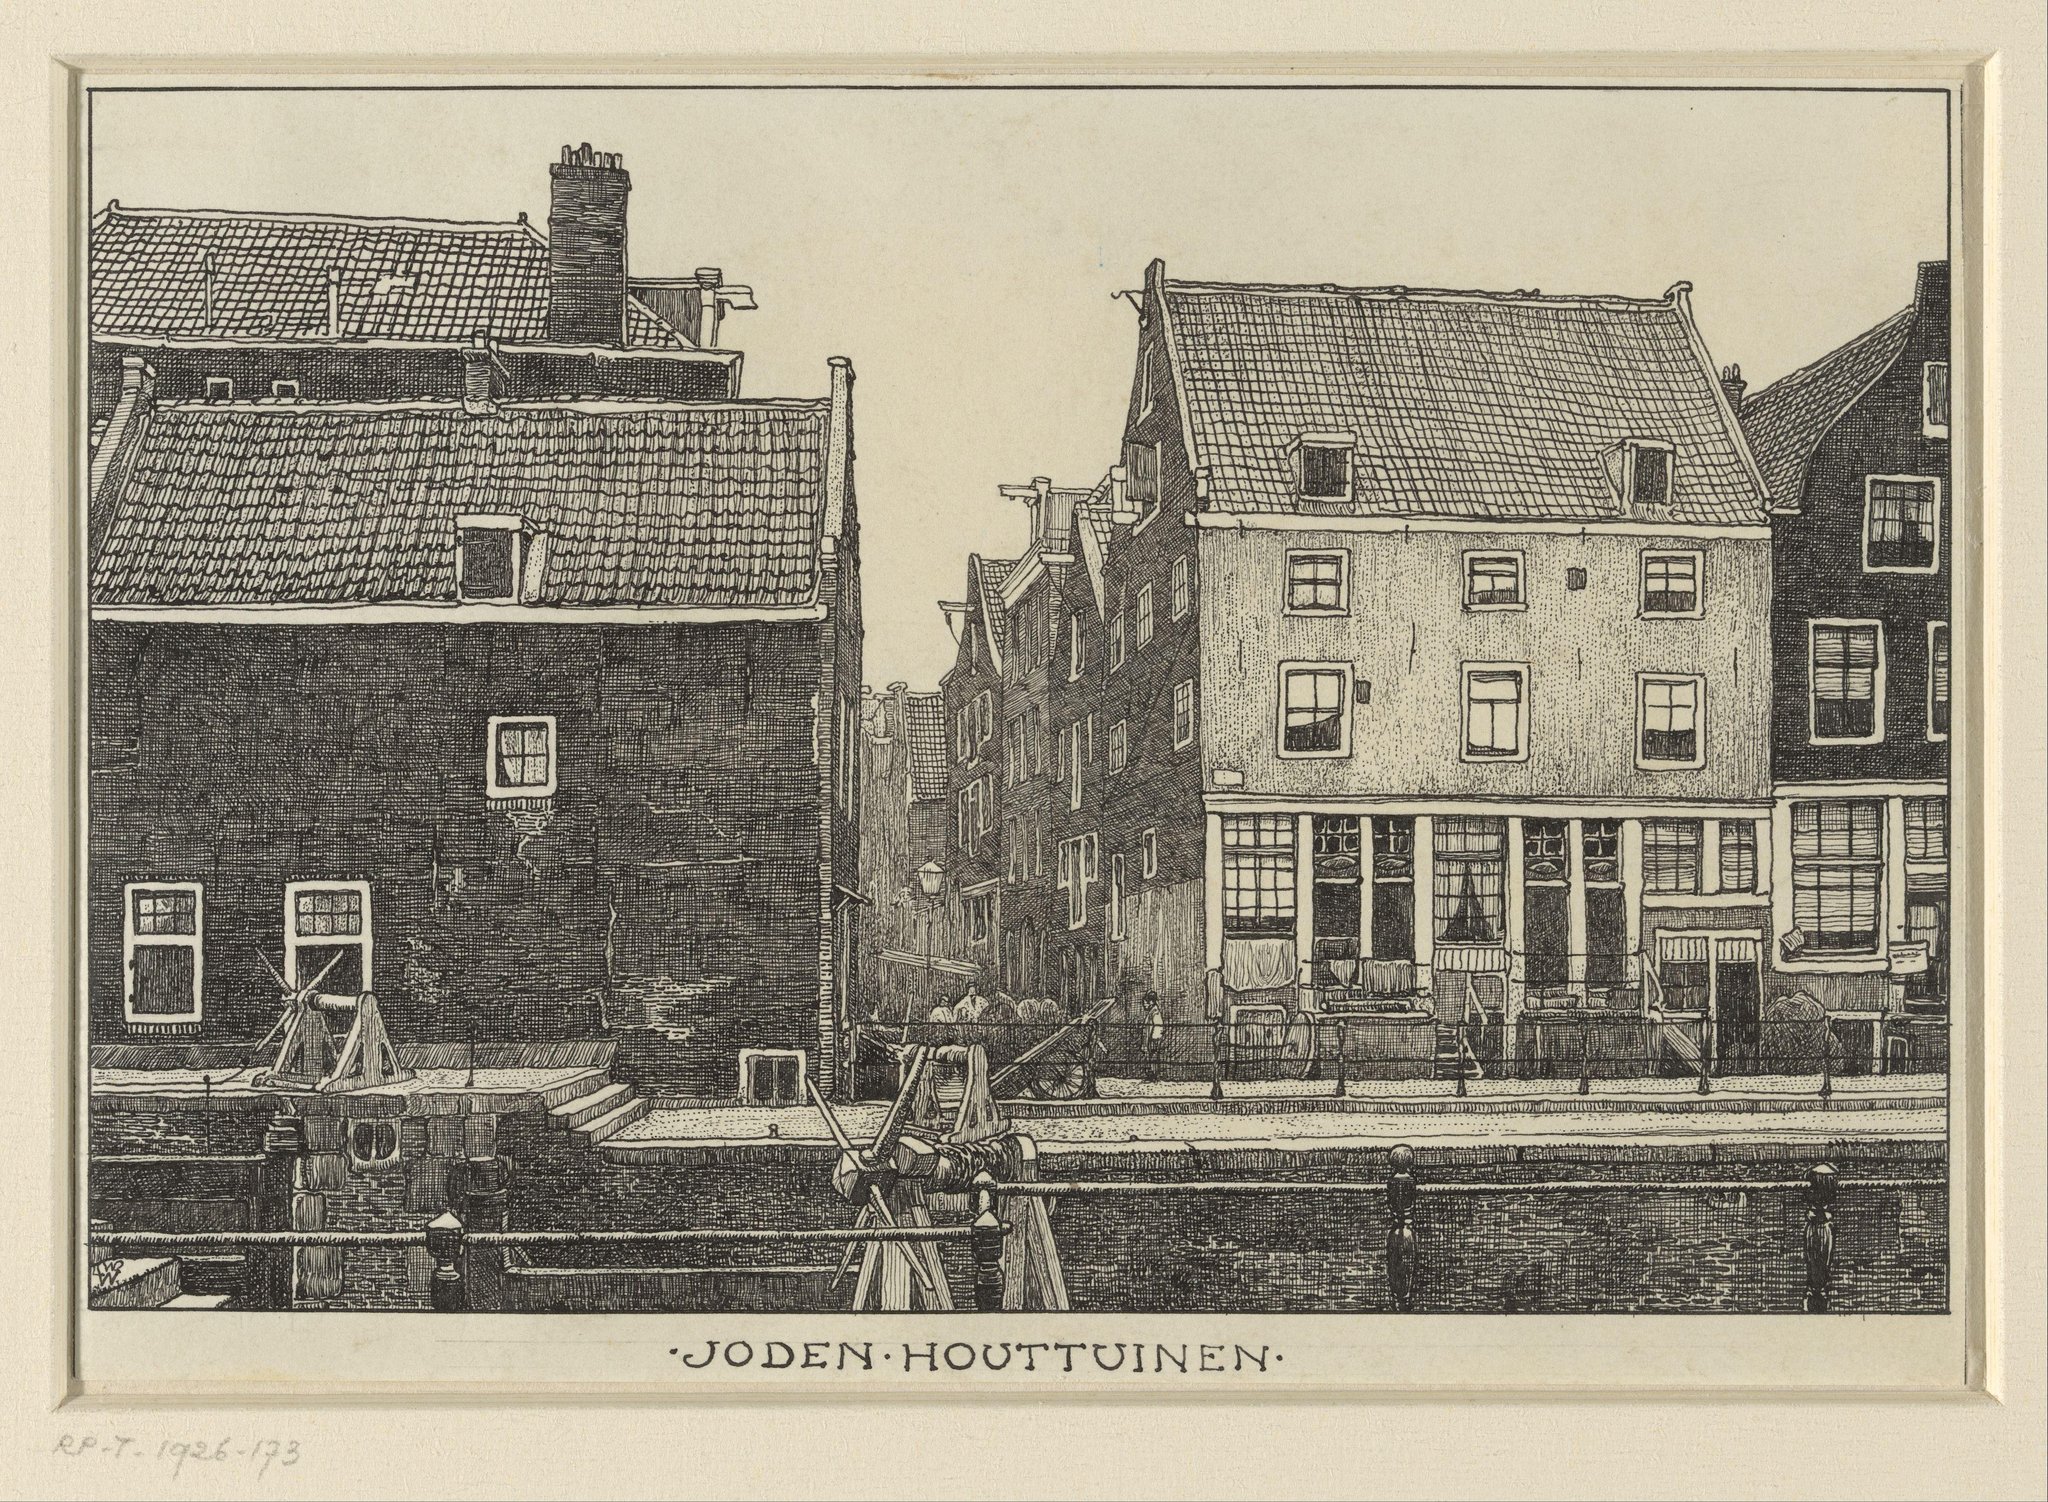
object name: drawing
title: Joden Houttuinen te Amsterdam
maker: willem wenckebach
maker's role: designer, draughtsman, painter, print maker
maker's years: 1860-1937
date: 1870-1926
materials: ink, paper, pencil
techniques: pen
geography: amsterdam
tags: street